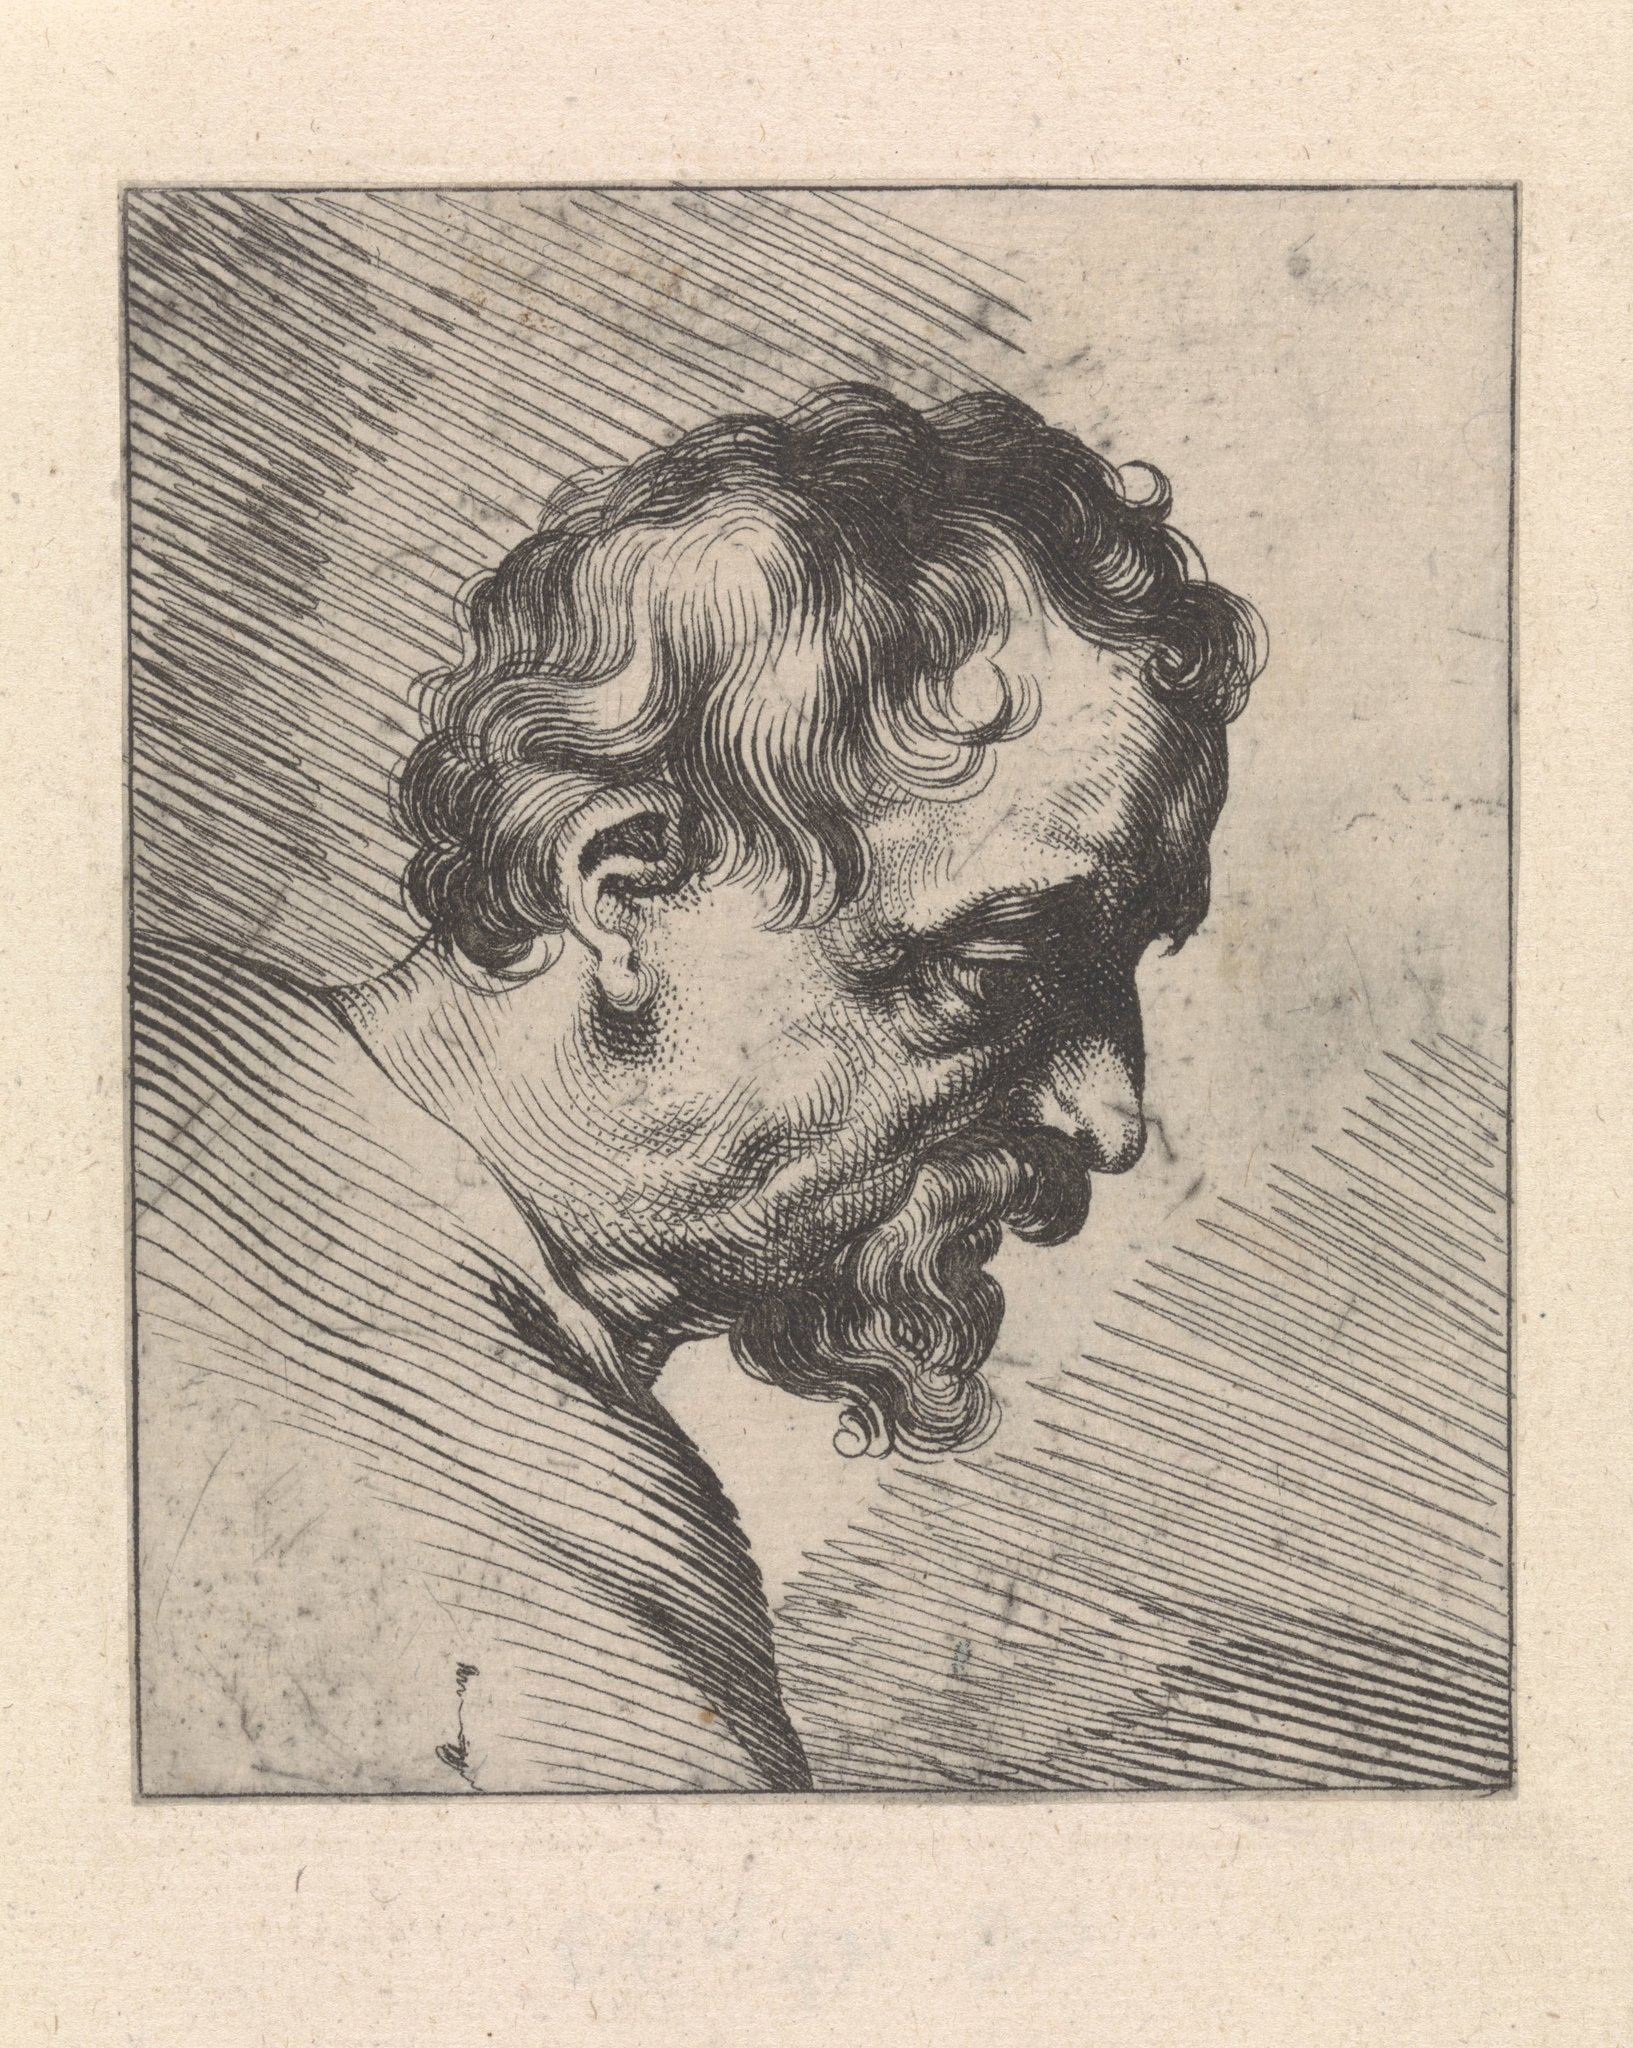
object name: print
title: Hoofden van apostelen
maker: theodorus van kessel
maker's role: print maker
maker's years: 1620-1660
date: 1630-1660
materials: paper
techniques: engraving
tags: (single) apostle, unspecified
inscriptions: collector's mark: Lugt 240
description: Buste van een apostel in profiel naar rechts, met zijn hoofd een fractie naar beneden gebogen. Deze prent maakt deel uit van een zevendelige serie over verschillende apostelen.